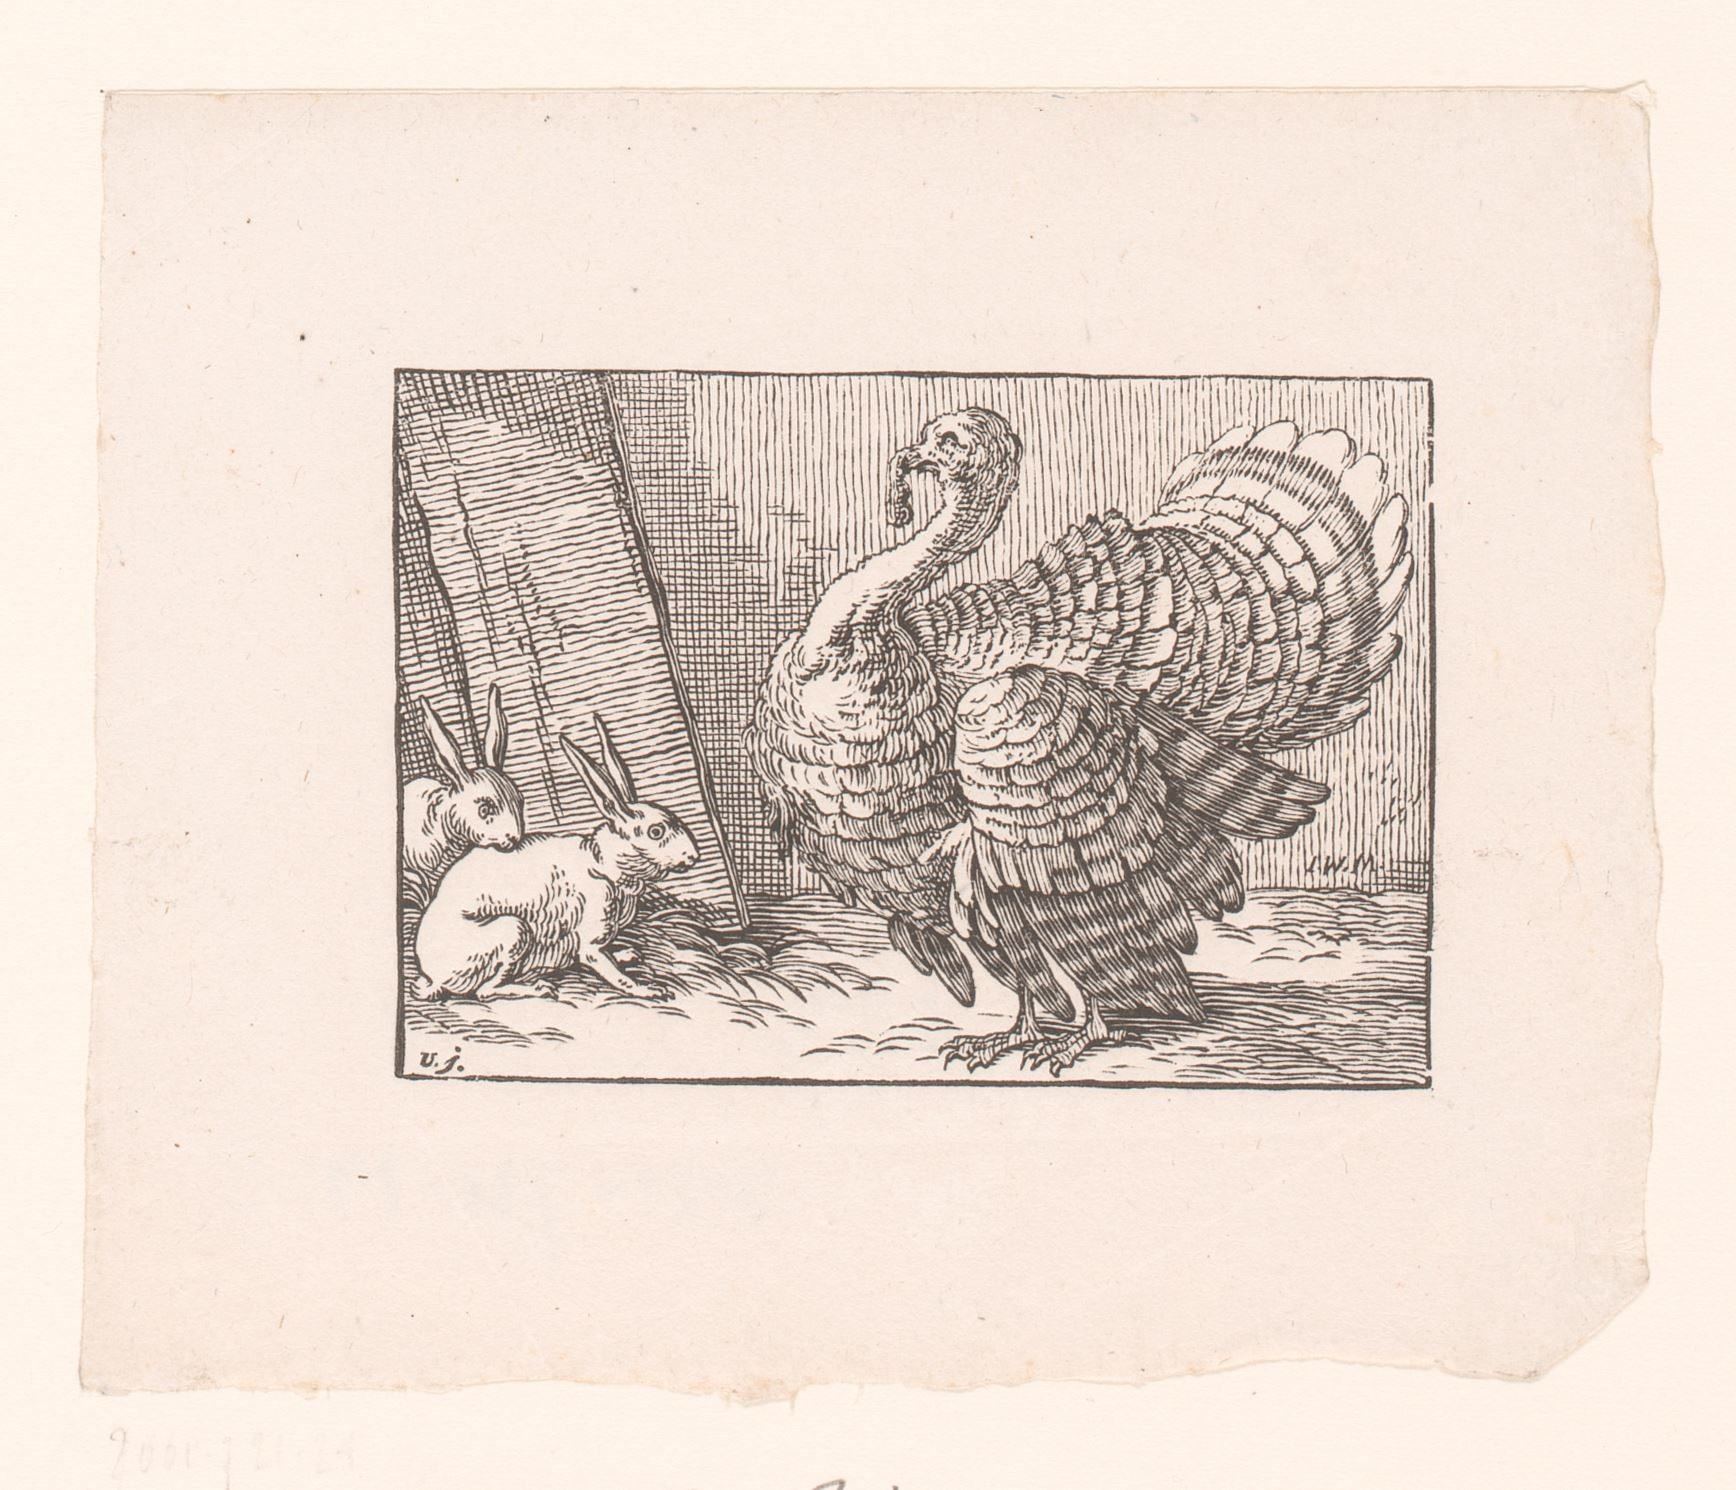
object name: print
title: 25 figuren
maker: johann friedrich gottlieb unger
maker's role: print maker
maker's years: 1753-1804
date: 1763-1804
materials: paper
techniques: woodcut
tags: walker and runner birds: turkey, rodents: rabbit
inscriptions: collector's mark: Lugt 2228